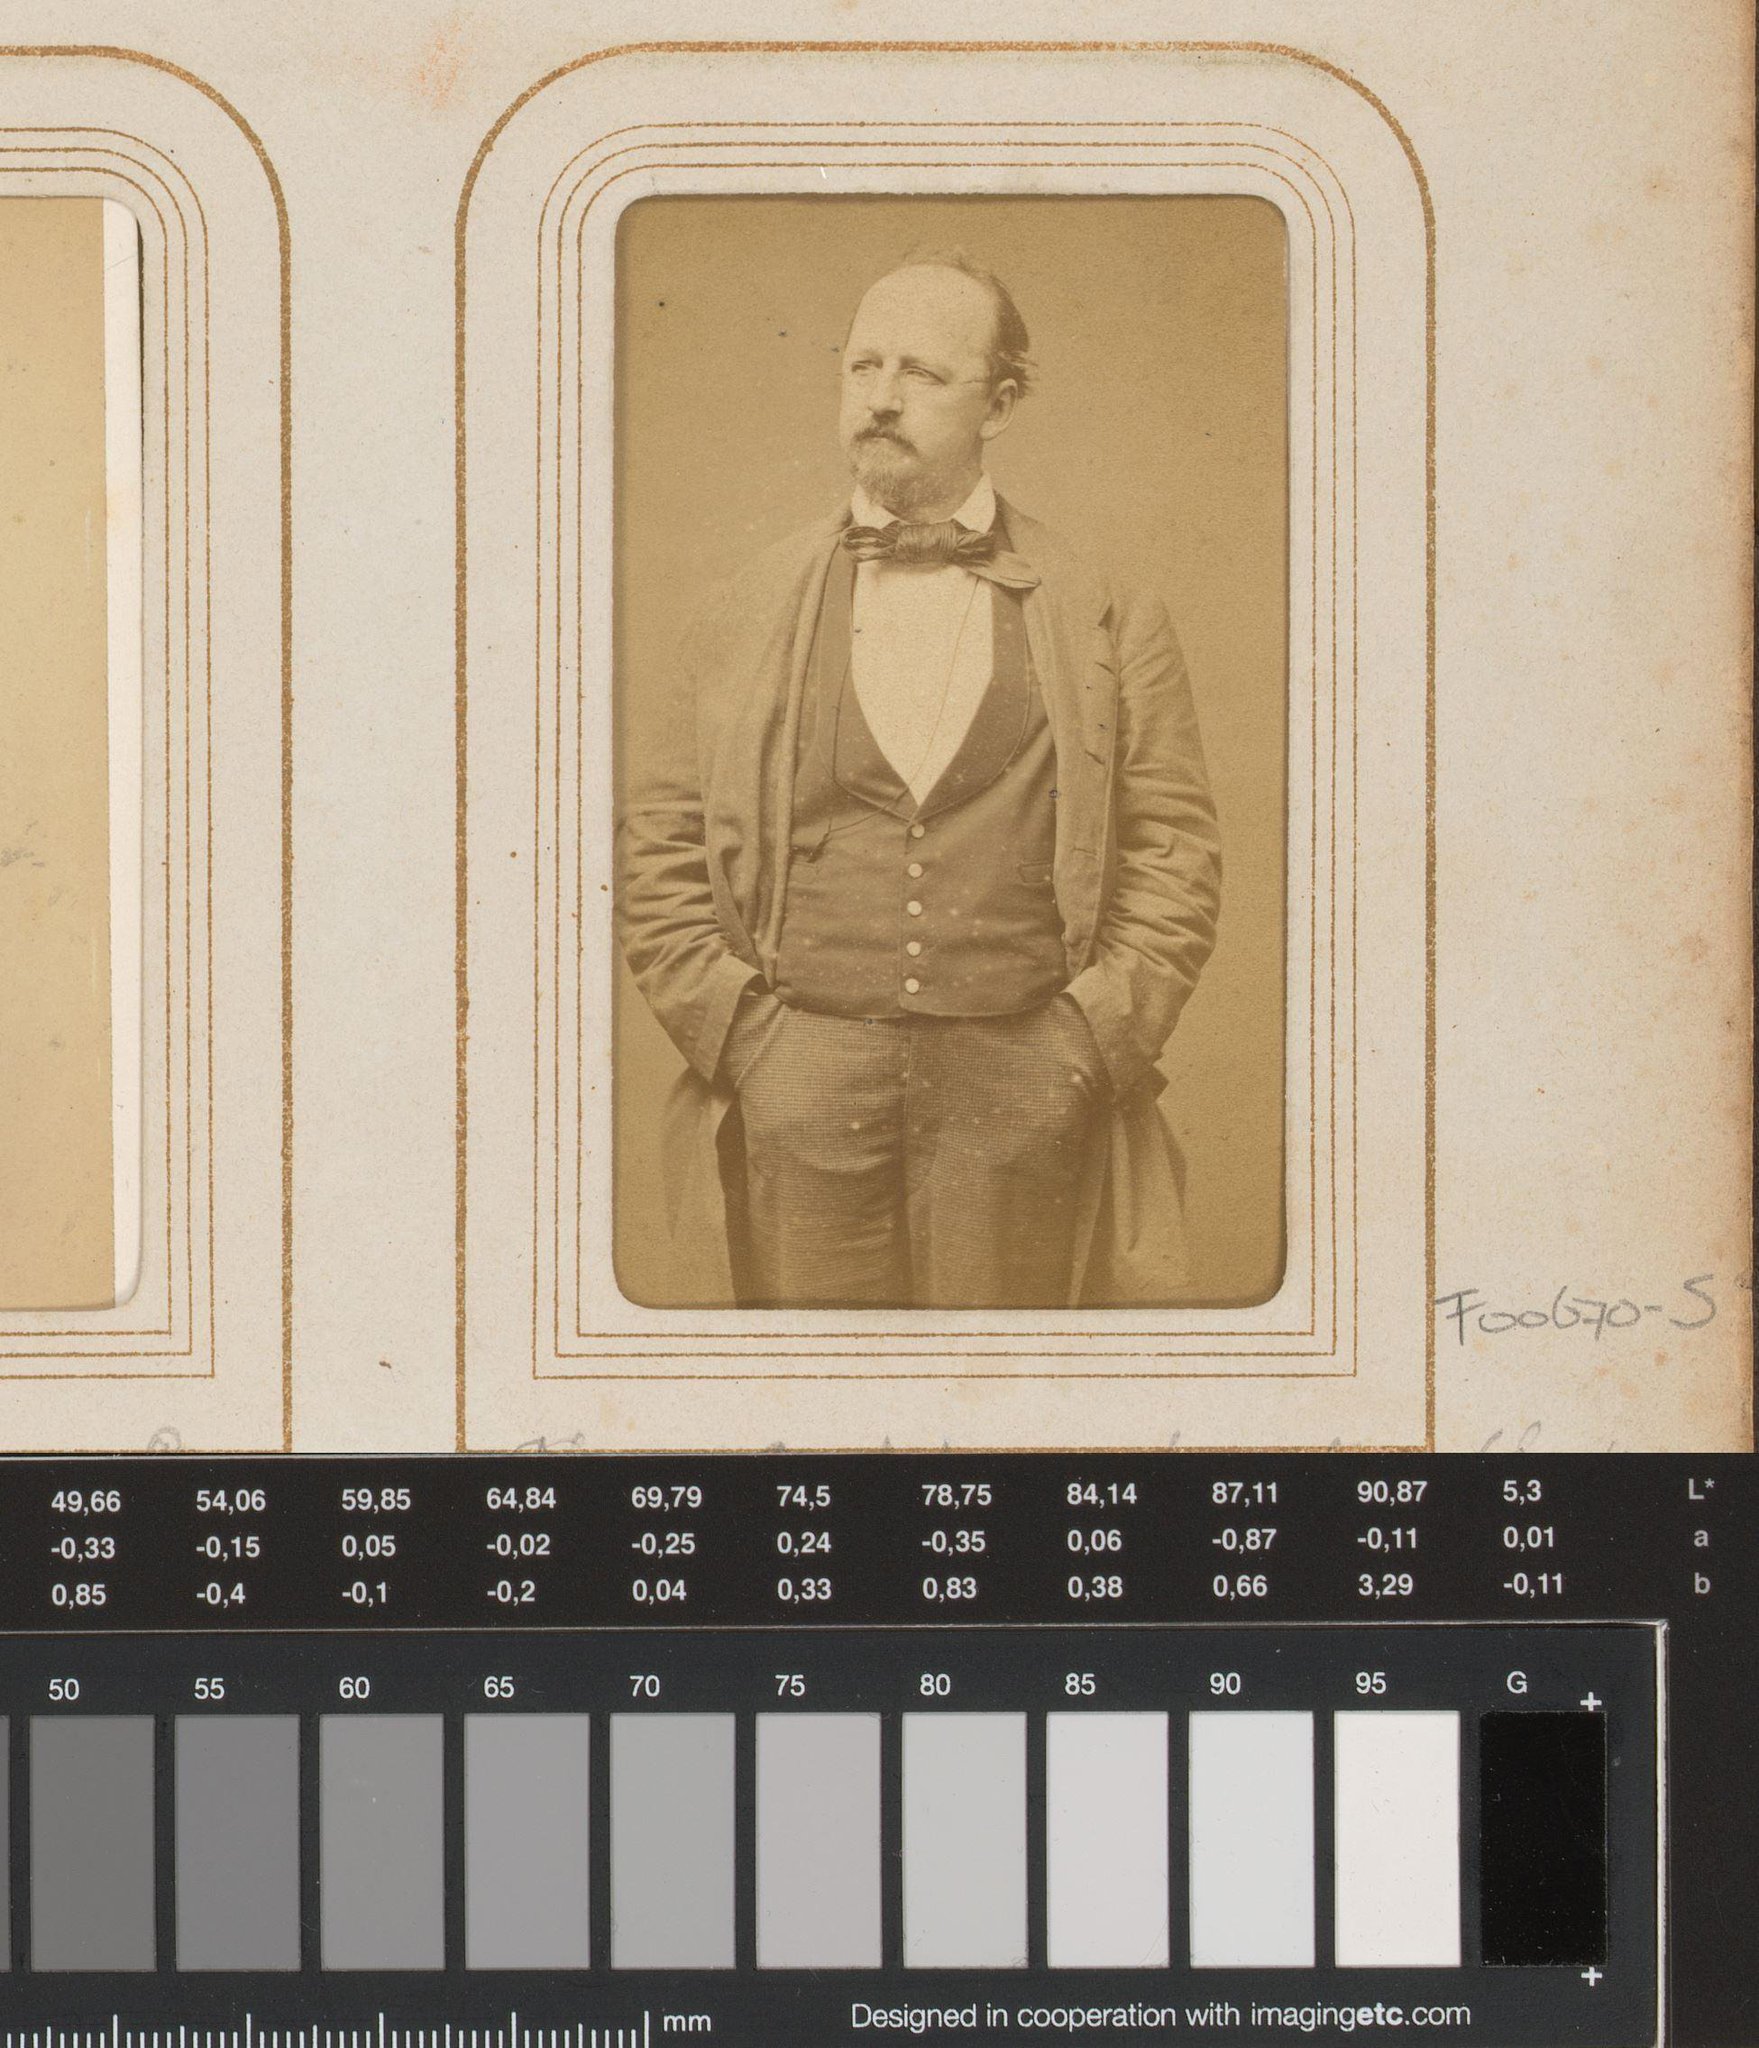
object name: carte de visite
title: Portret van Emile Erckmann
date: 1855-1870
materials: cardboard, photographic support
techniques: albumen print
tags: historical persons, writer, poet, author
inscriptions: annotation: ‘Emile Erckmann fr. schrijver/ duo Erckmann - Chatrian 1822-1899 [...]’, name: ‘Erckmann’, inscription: ‘Anne mon G. le Gray & Cie/ Photographie Artistique/ Fontaine/ 35, Boulev.d des Capucines/ Paris’